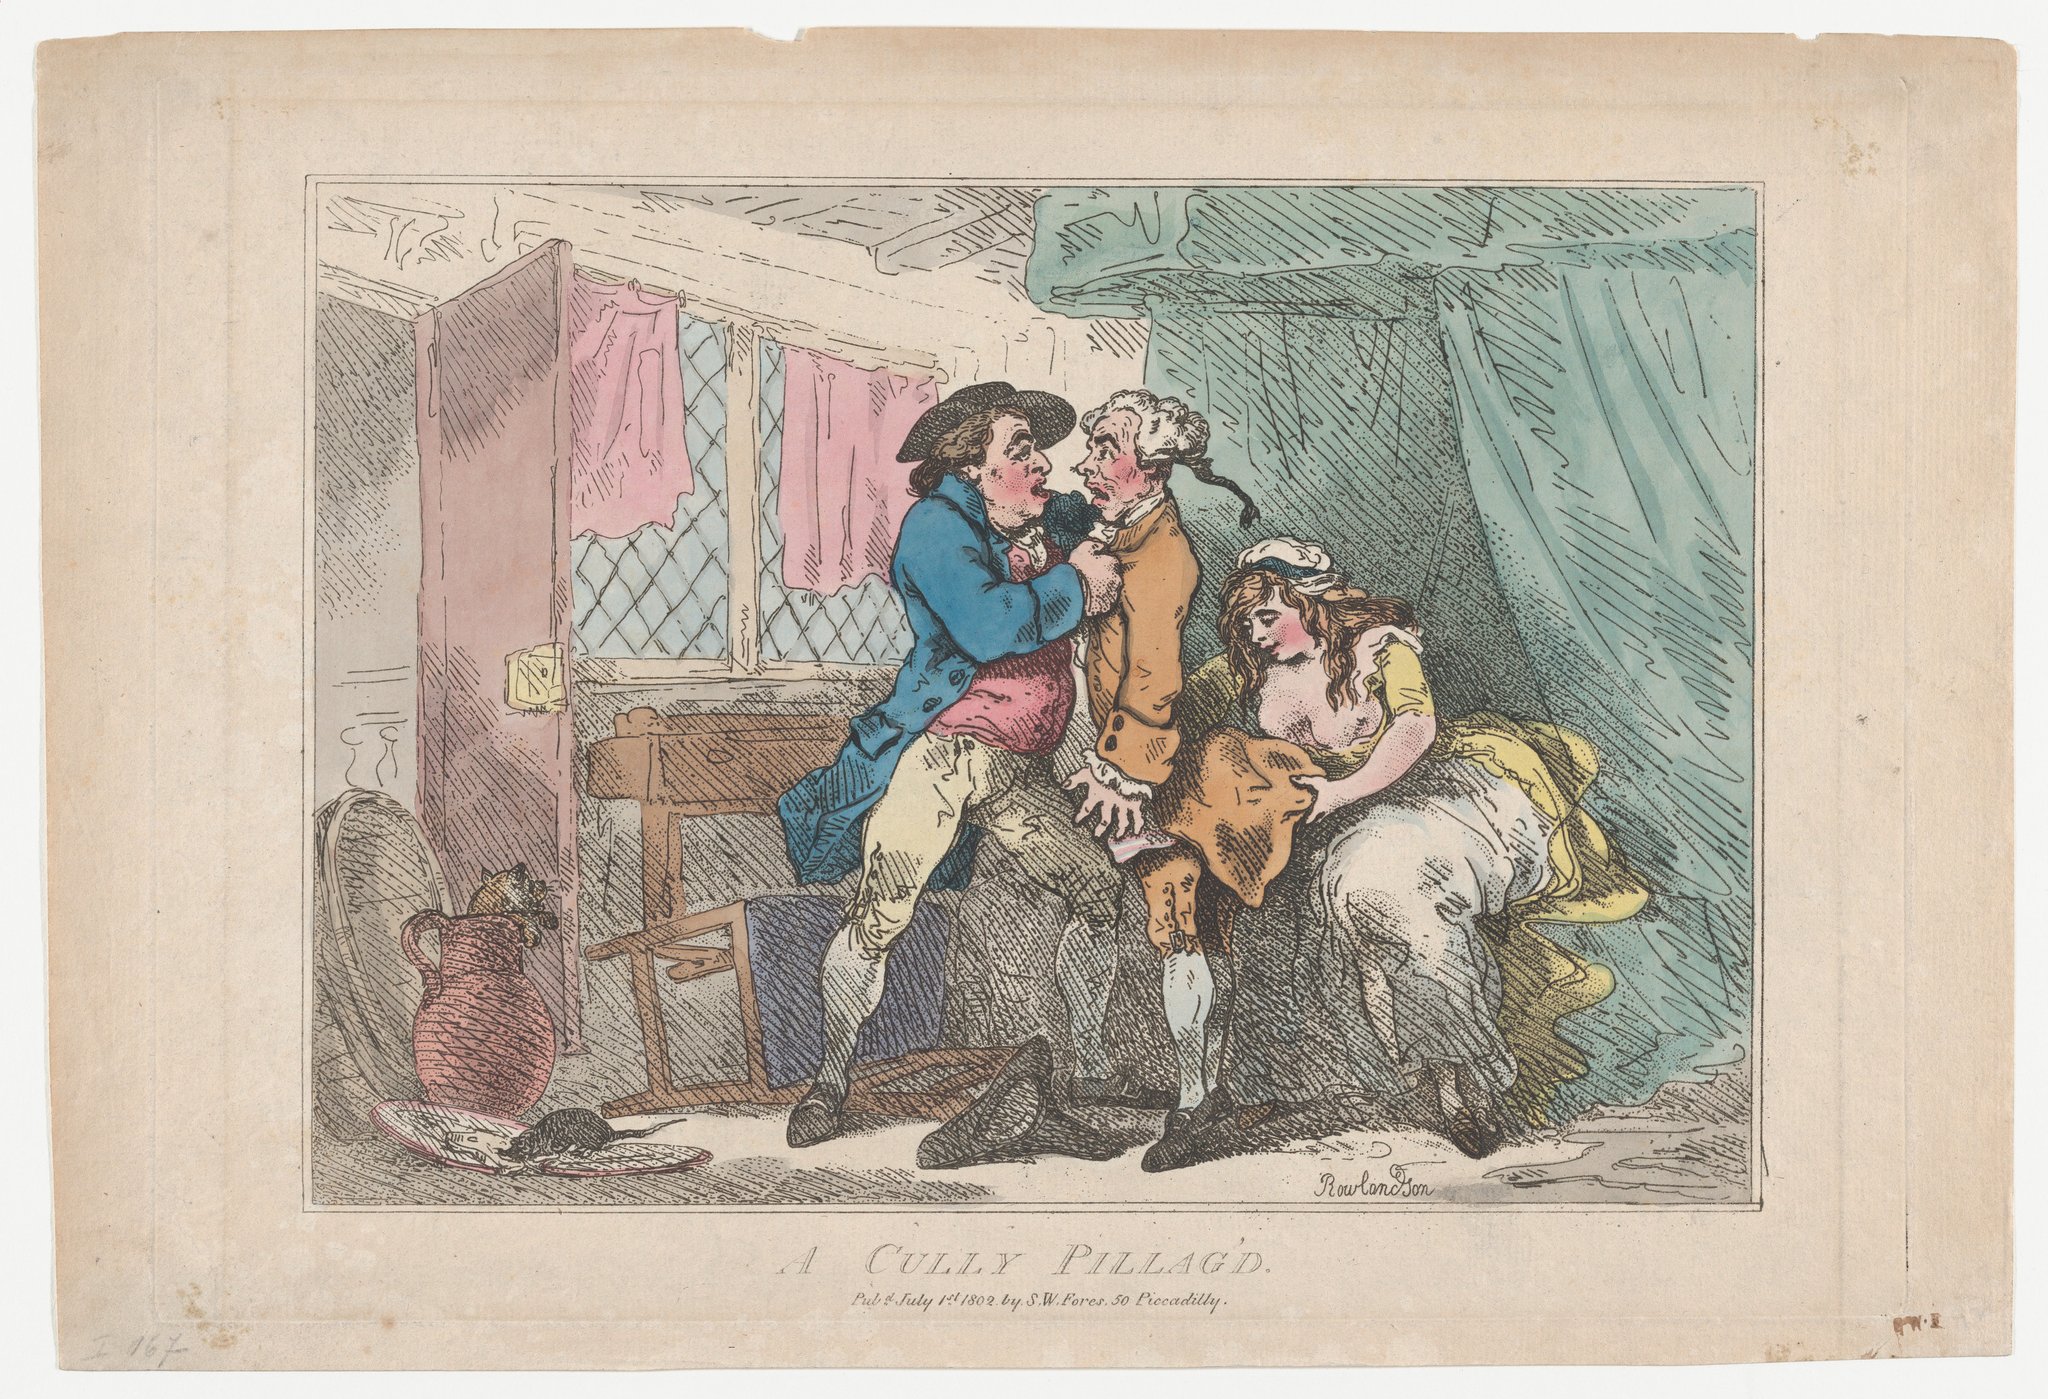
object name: print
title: A Cully Pillag'd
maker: thomas rowlandson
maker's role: artist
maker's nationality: british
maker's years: 1757-1827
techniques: etching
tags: men,women,cats,mice